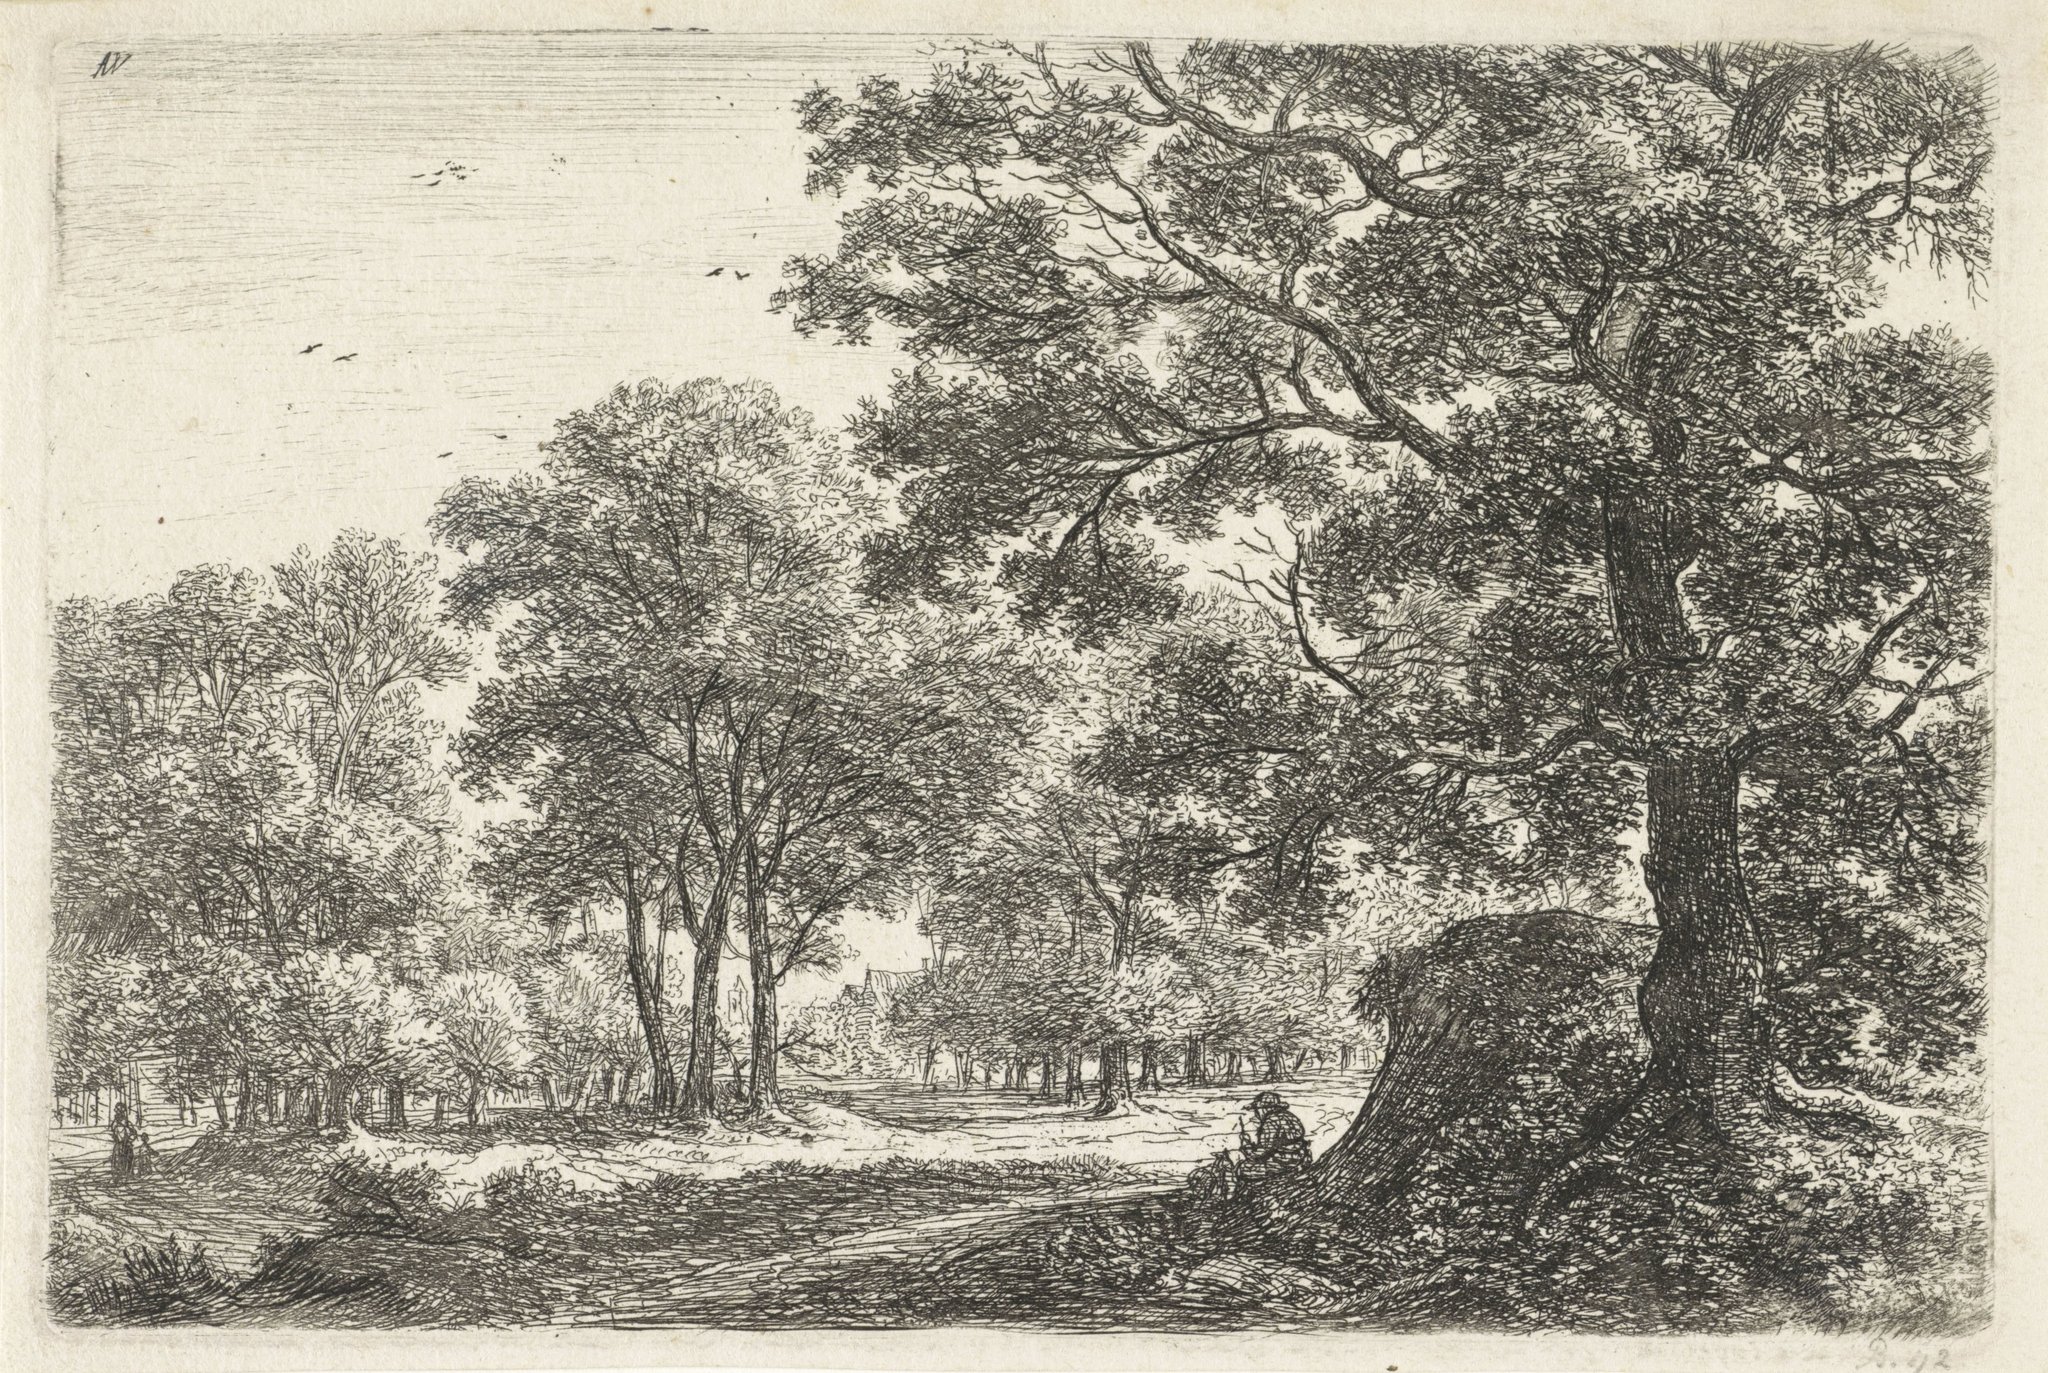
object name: print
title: Man met een hond langs een bospad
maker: anthonie waterloo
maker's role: draughtsman, painter, print maker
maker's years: 1609-1690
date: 1630-1663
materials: paper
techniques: etching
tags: forest path or lane, landscapes (+ landscape with figures, staffage), dog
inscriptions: collector's mark: Lugt 2228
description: Langs een bospad zit een man met zijn hond aan de voet van een verhoging in het landschap. Links wandelen twee figuren. Rechts staat een grote boom en de verte is bebouwing te zien.